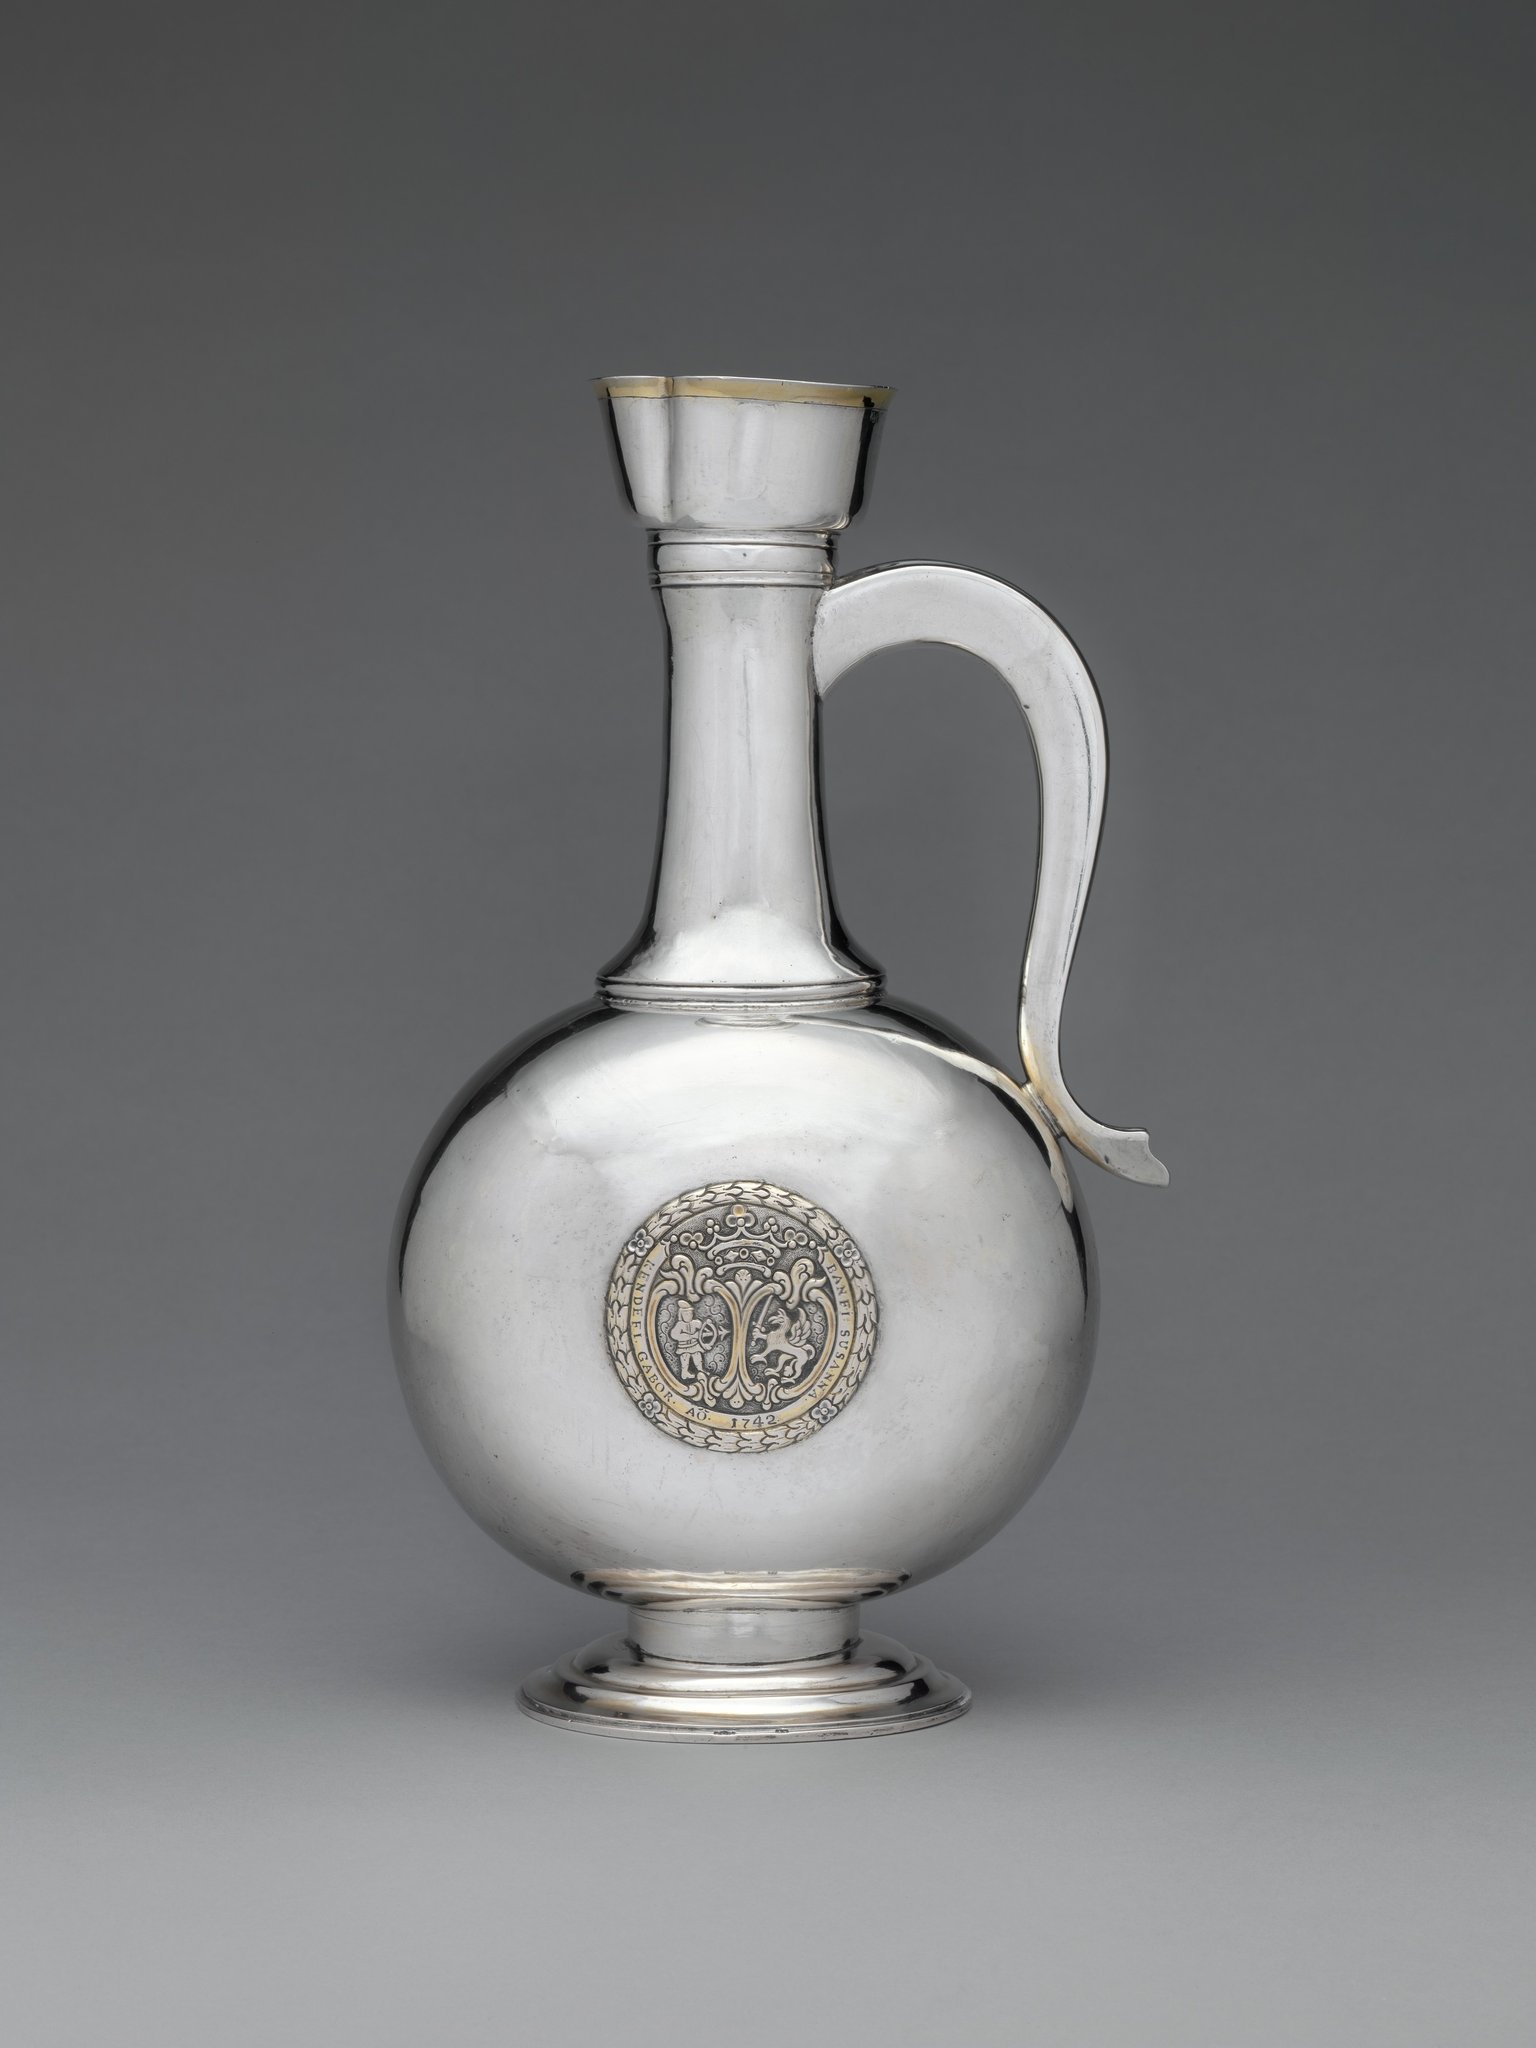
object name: wine decanter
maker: johannes szakáll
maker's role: maker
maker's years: 1748-1772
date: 1779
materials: silver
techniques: gilding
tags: coat of arms